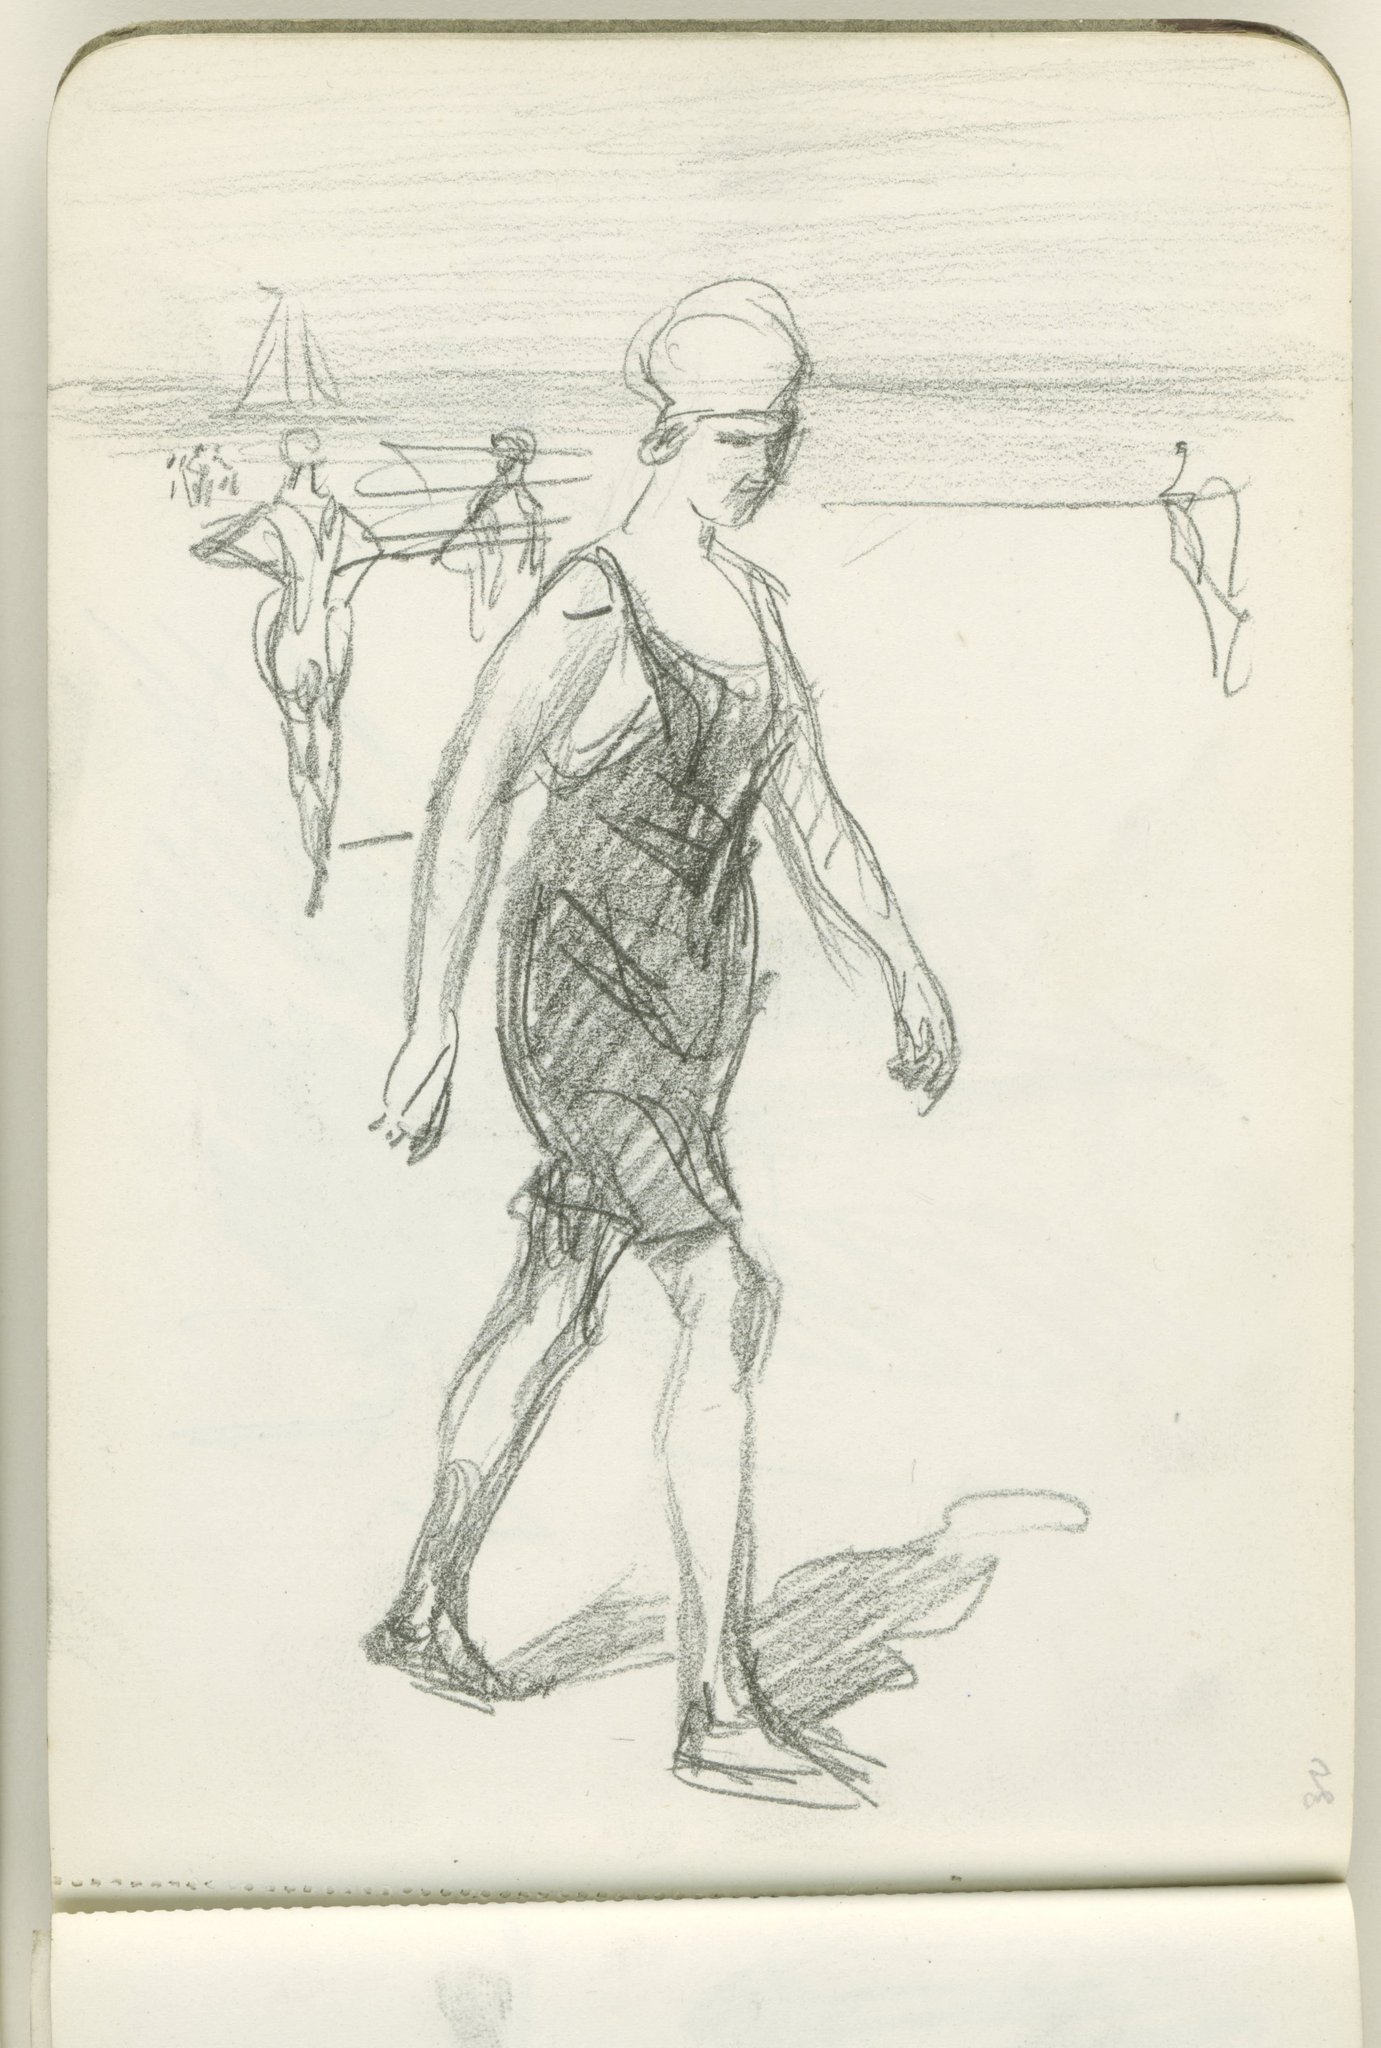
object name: sketchbook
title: Schetsboek LX met 33 bladen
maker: isaac israels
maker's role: draughtsman, painter, print maker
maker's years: 1865-1934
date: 1875-1934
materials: cardboard, chalk, ink, linen, paper, pencil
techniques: pen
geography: the hague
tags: in or beside the water (on the beach)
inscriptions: collector's mark: Lugt 2228, inscription: ‘Carnet Croquis’, inscription: ‘Pour obtenir le même carnet / demander le / Carnet Croquis / No. 1020 / Canson & Montgolfier’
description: Bladen 1(V), 2(R), 3(V), 9(V), 10(V), 11(V), 13(V), 17, 20(V), 22(R), 24(V), 29(R), 31(R), 32 en 33(R) zijn blanco en daarom niet beschreven.